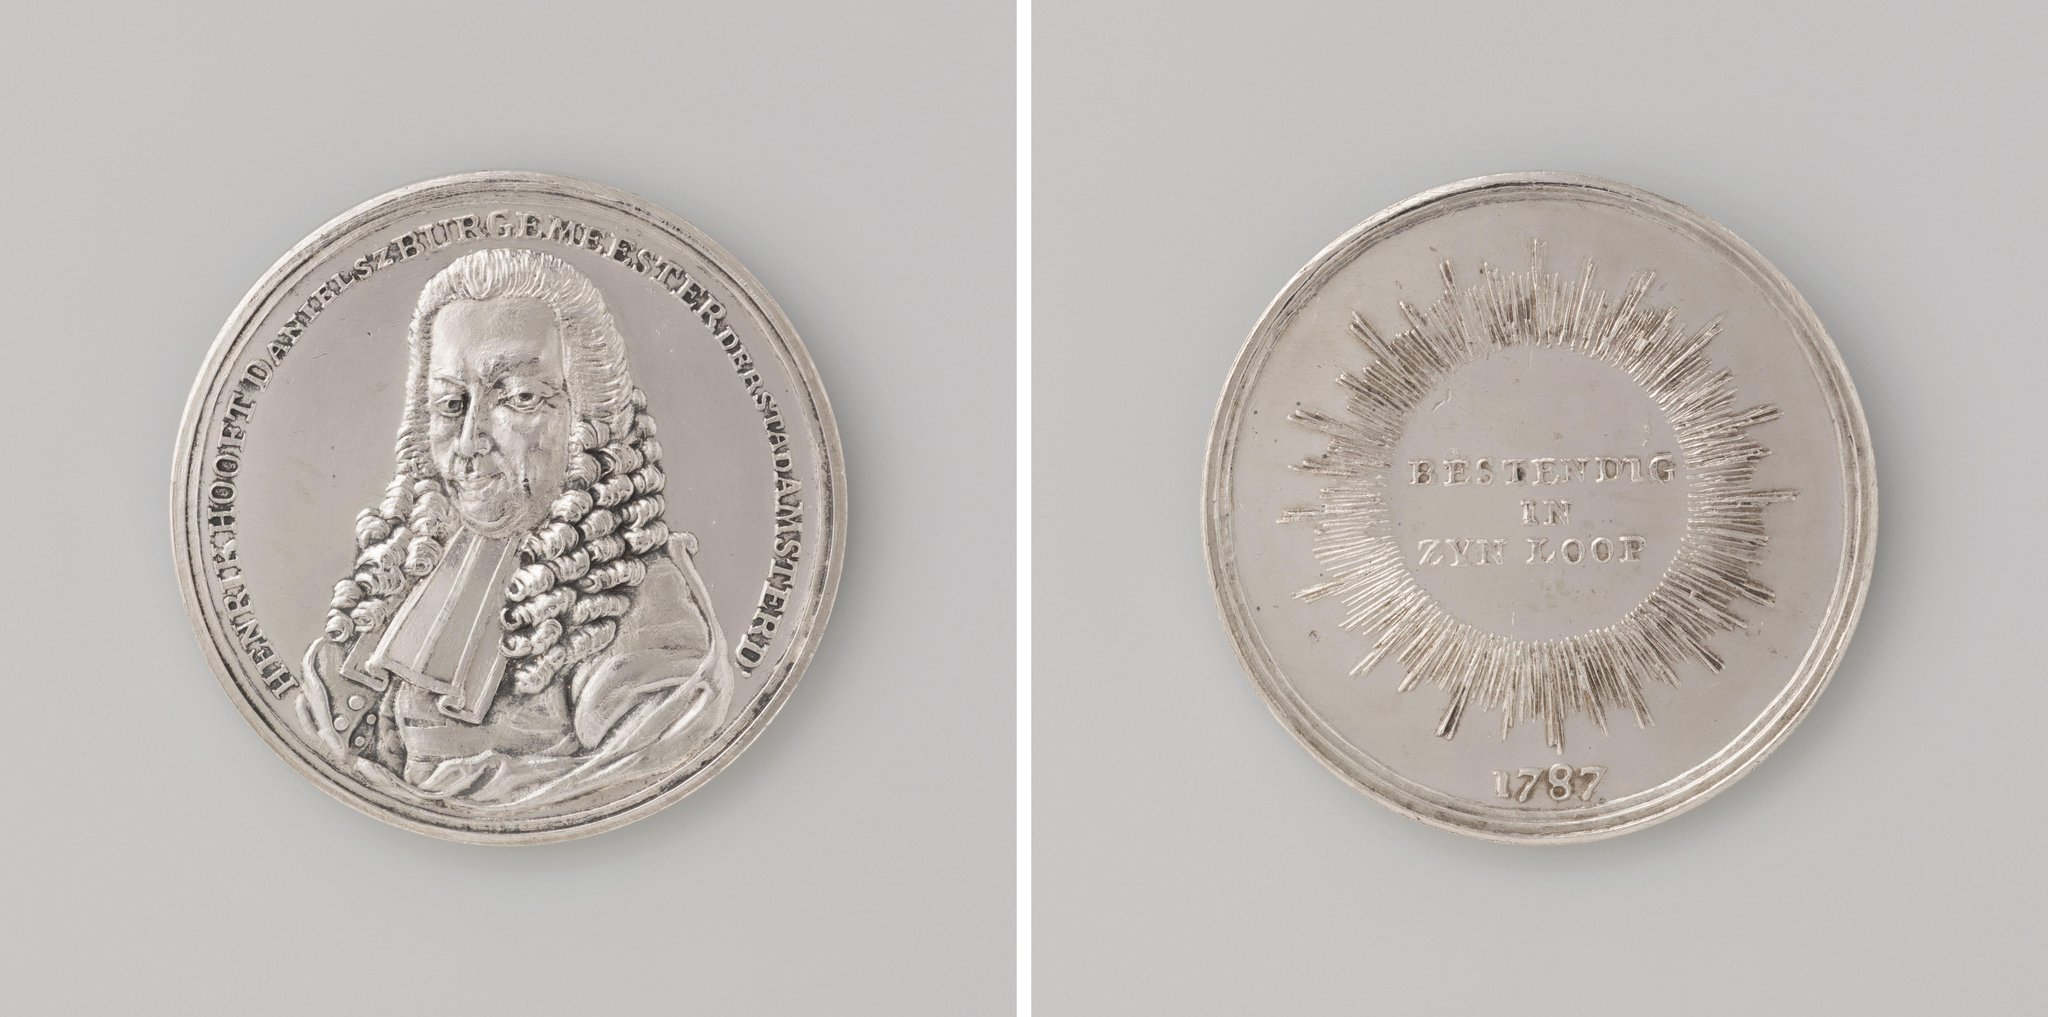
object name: history medal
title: Hendrik Danielsz. Hooft, burgemeester van Amsterdam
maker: Anonymous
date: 1787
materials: silver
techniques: striking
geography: netherlands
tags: amsterdam, hendrik danielsz. hooft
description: Zilveren penning. Voorzijde: borststuk man binnen omschrift. Keerzijde: opschrift binnen stralenkrans boven jaartal